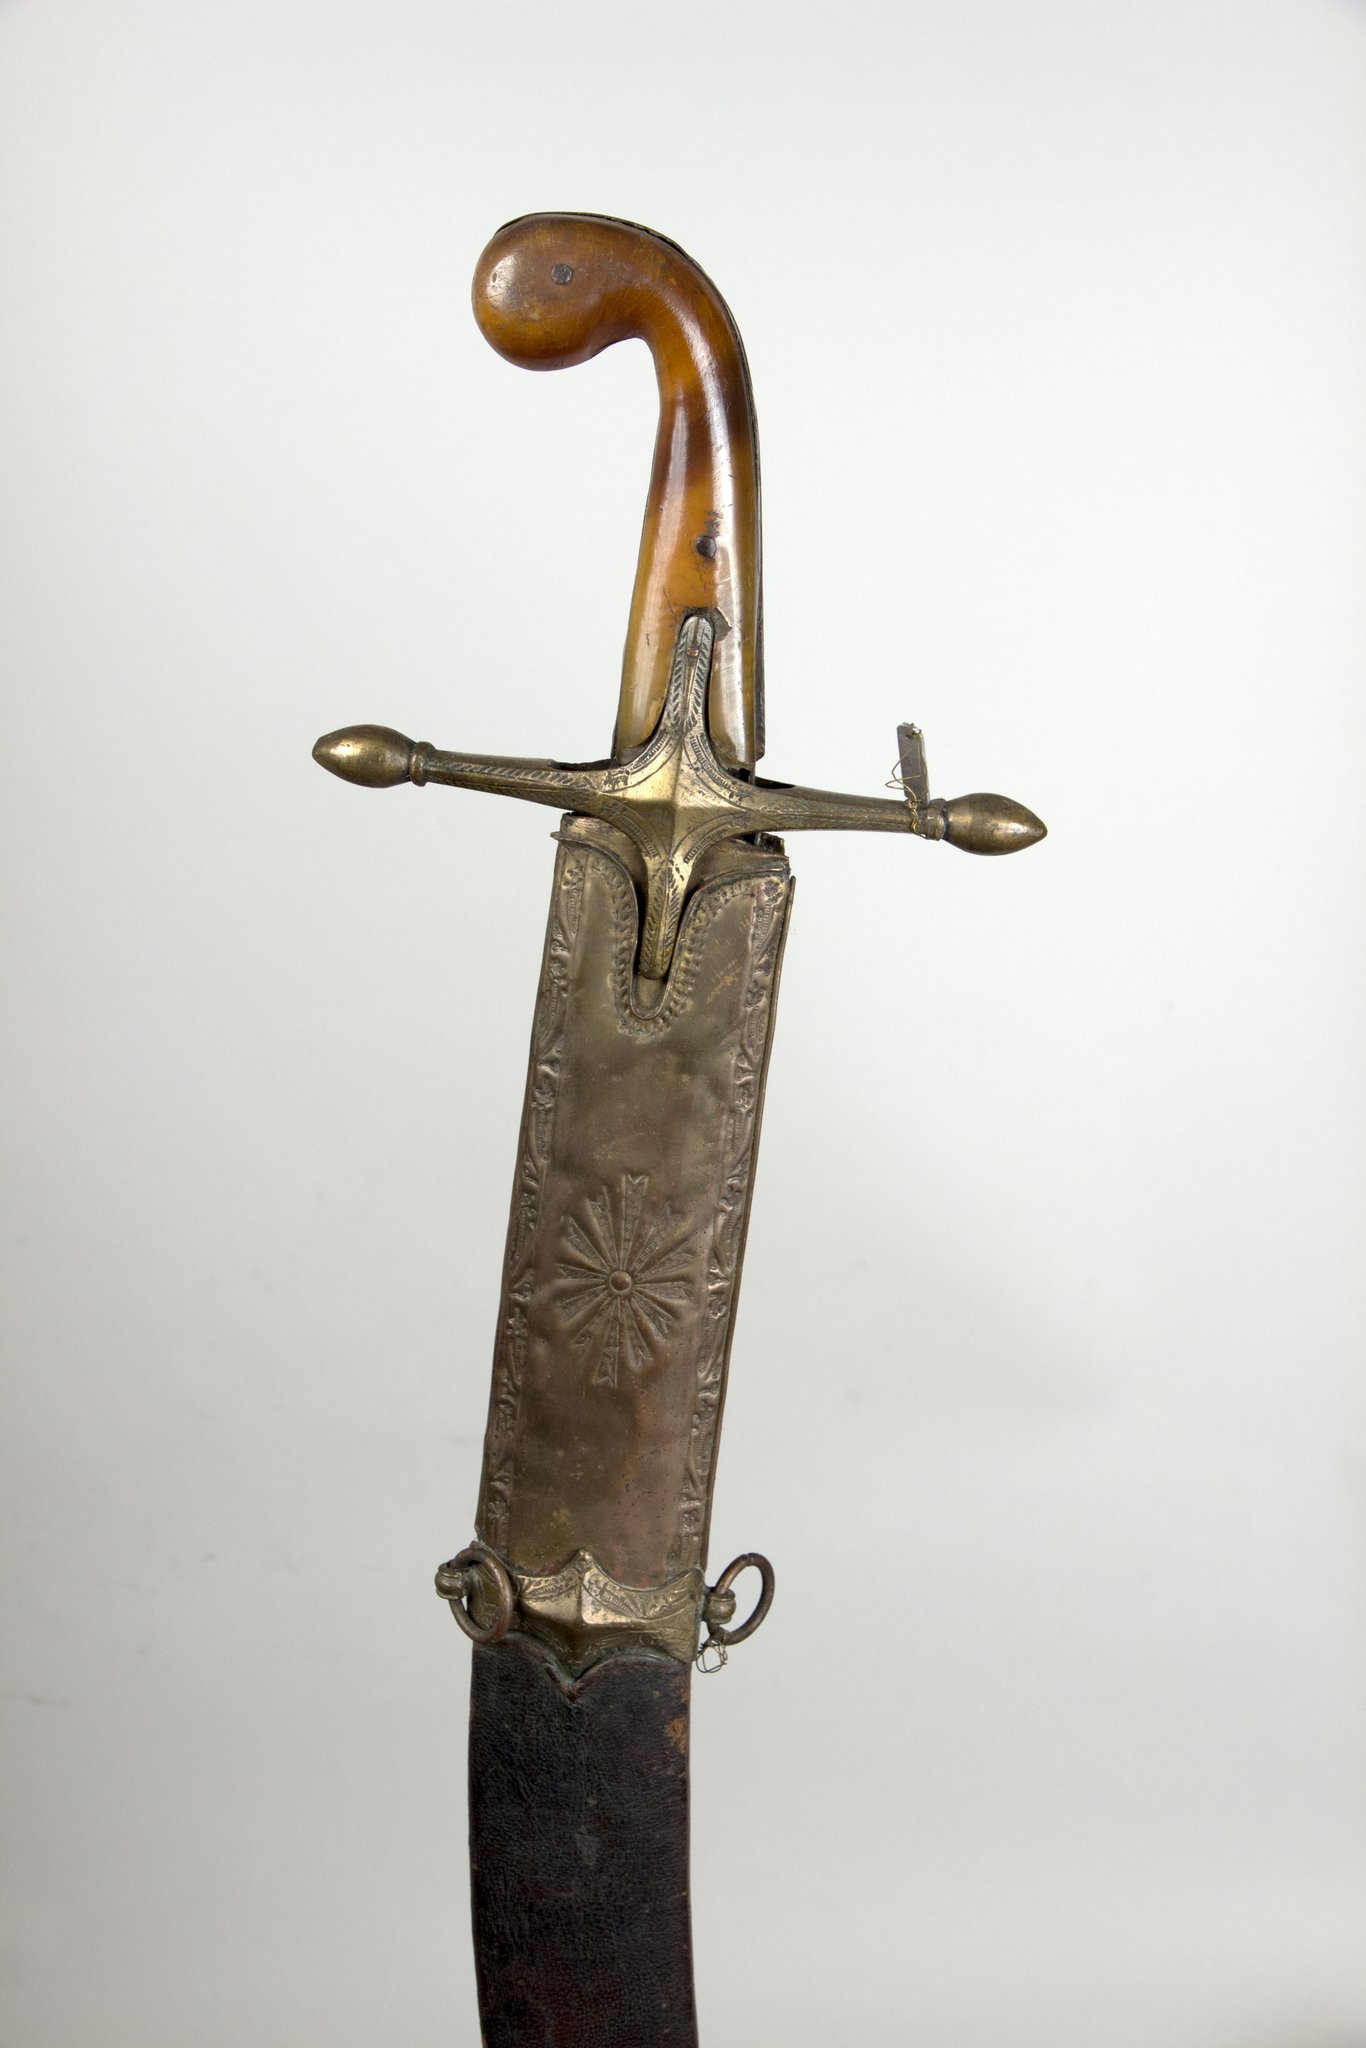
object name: sword kilij with scabbard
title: Sword (Kilij) with Scabbard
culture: turkish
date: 1701-1800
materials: brass, horn, steel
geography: ottoman empire